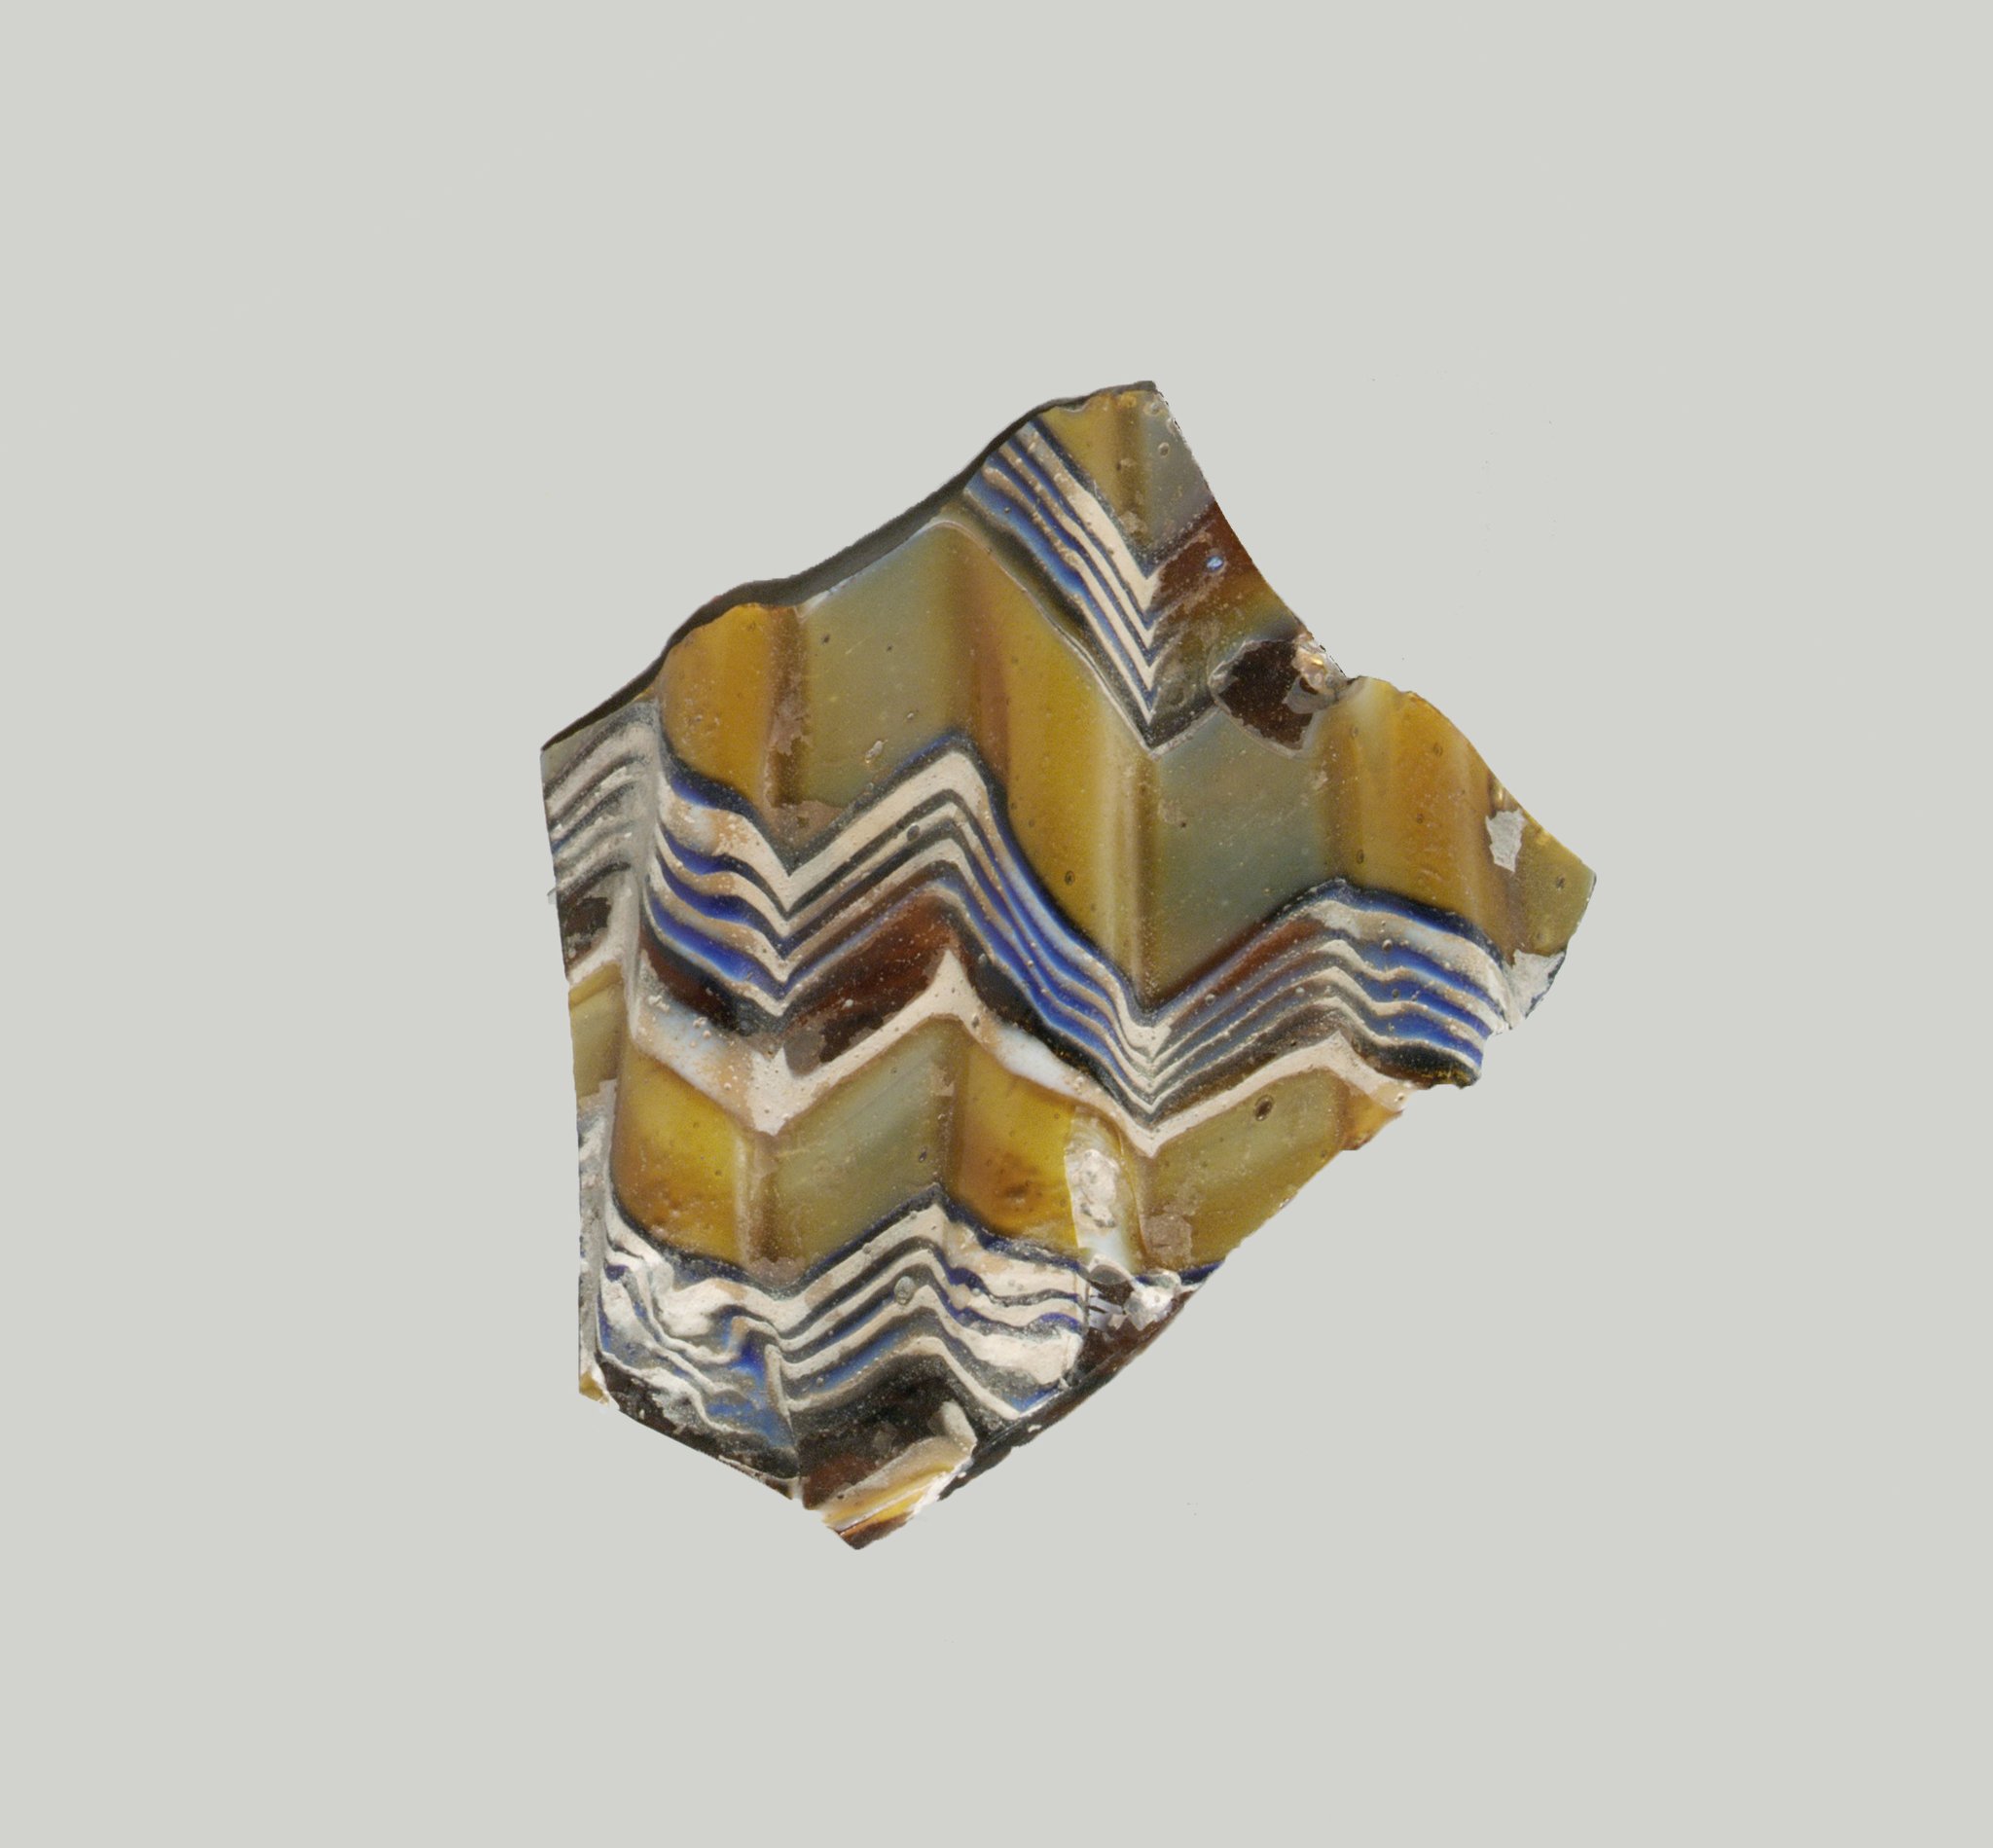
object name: fragment, mosaic bowl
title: Glass mosaic ribbed bowl fragment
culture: roman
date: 34 BCE-33 CE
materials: glass